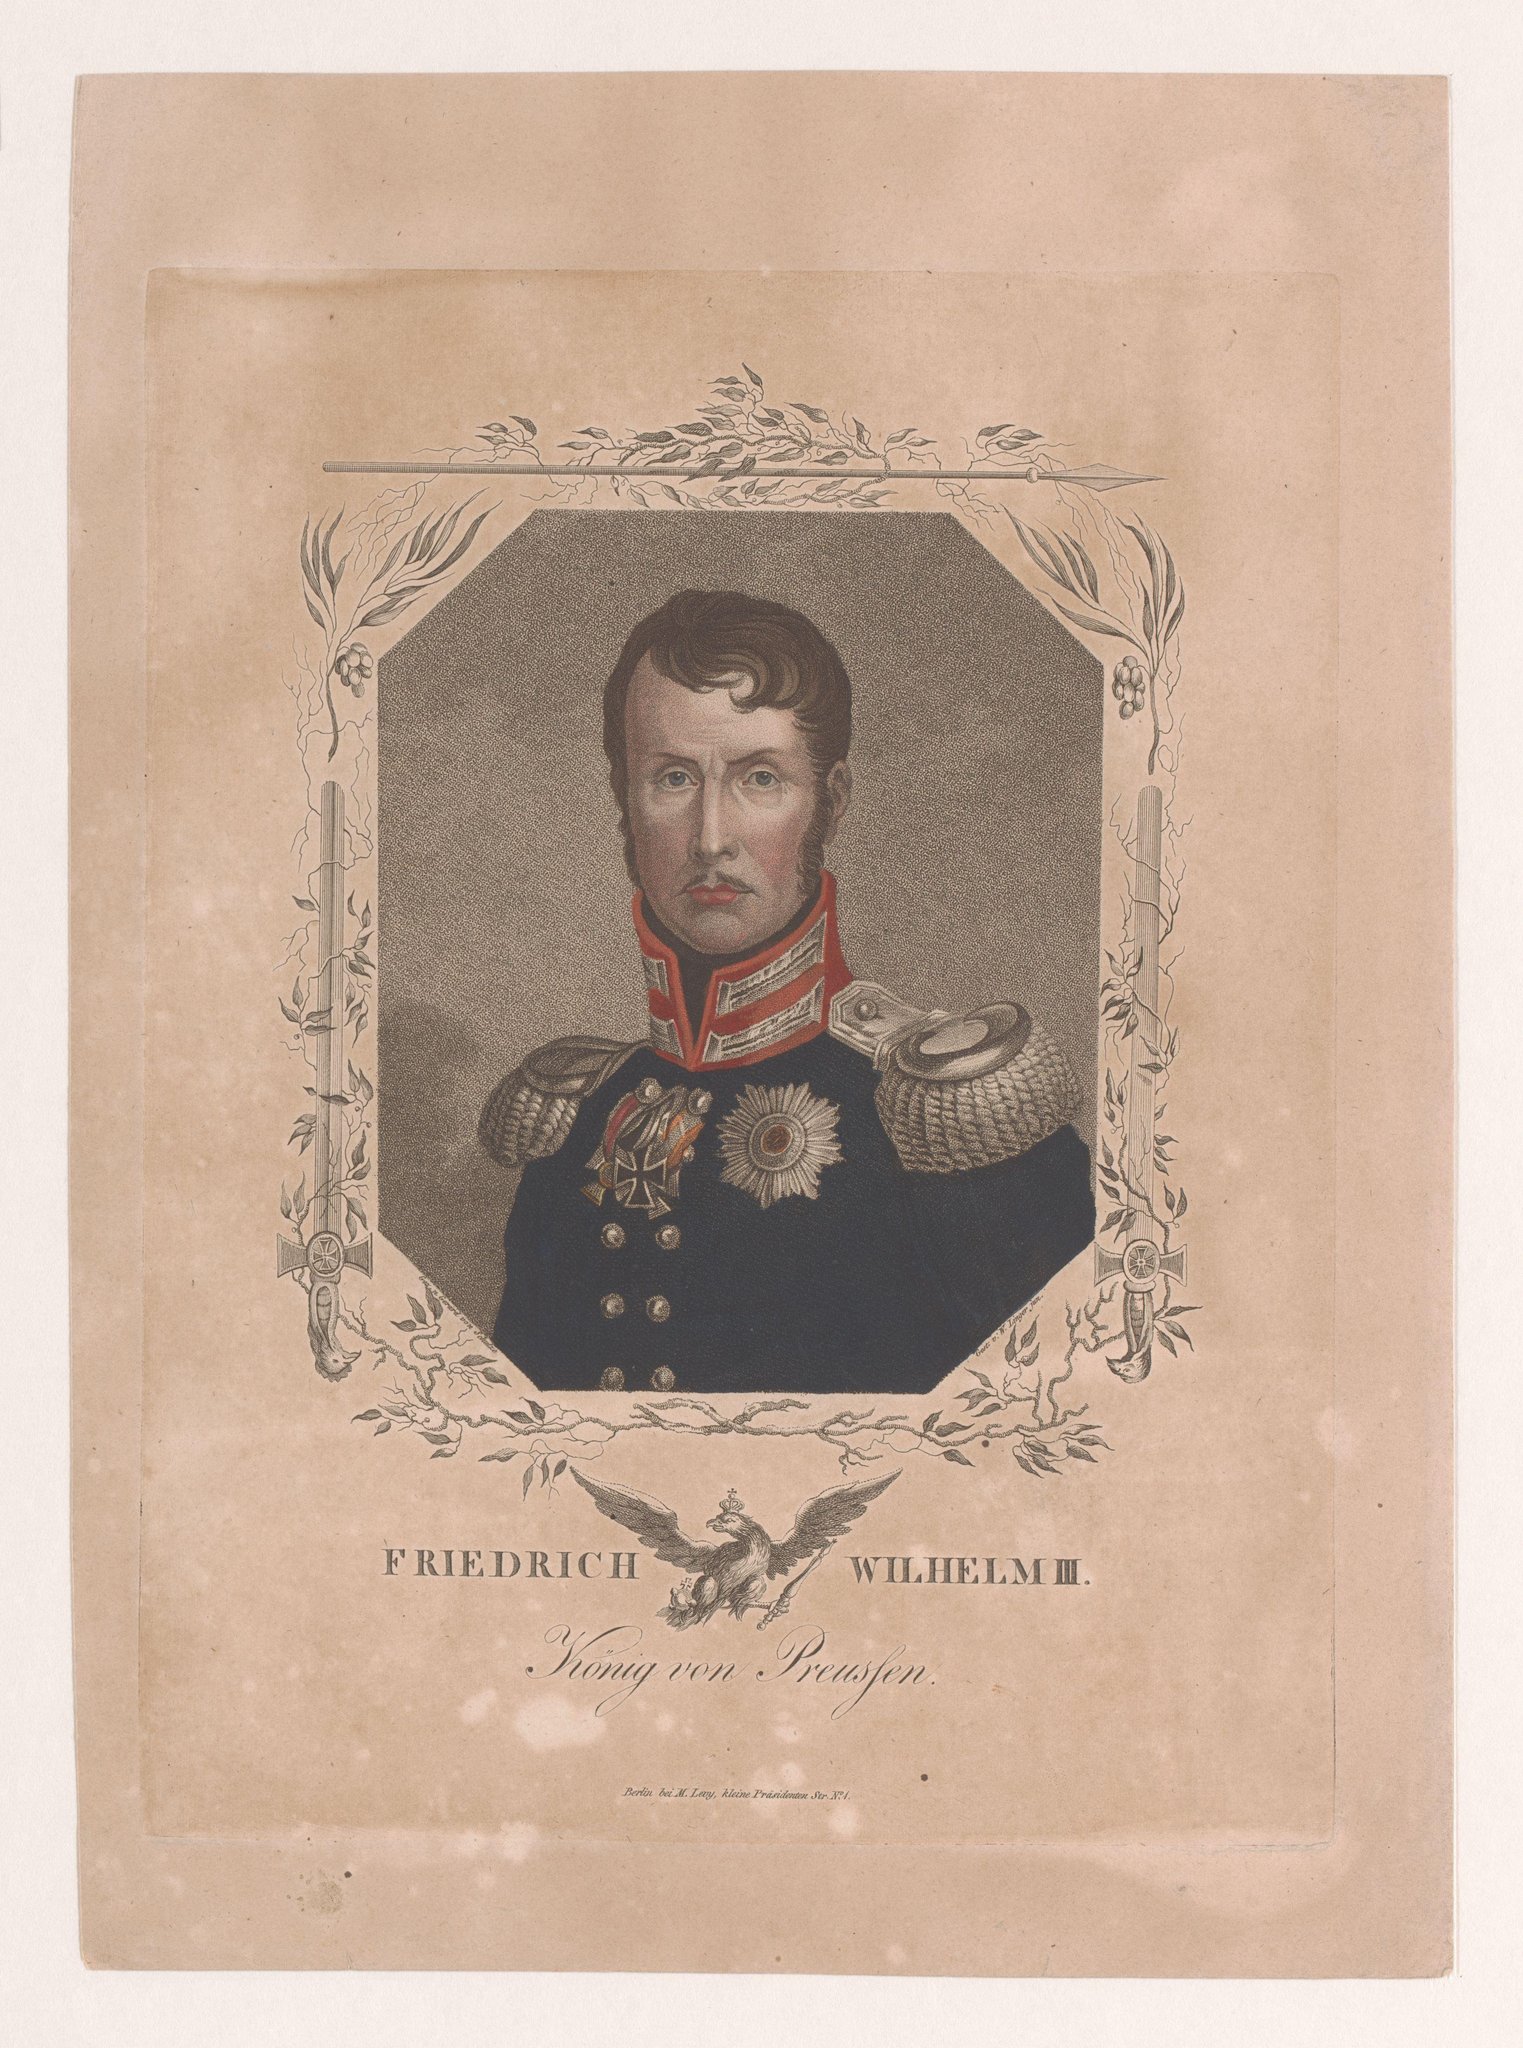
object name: print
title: Portret van Frederik Willem, koning van Pruisen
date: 1821-1840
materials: paper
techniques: hand coloring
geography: berlin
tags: berlin, frederik willem iii koning van pruisen, historical persons, king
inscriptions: collector's mark: Lugt 2228